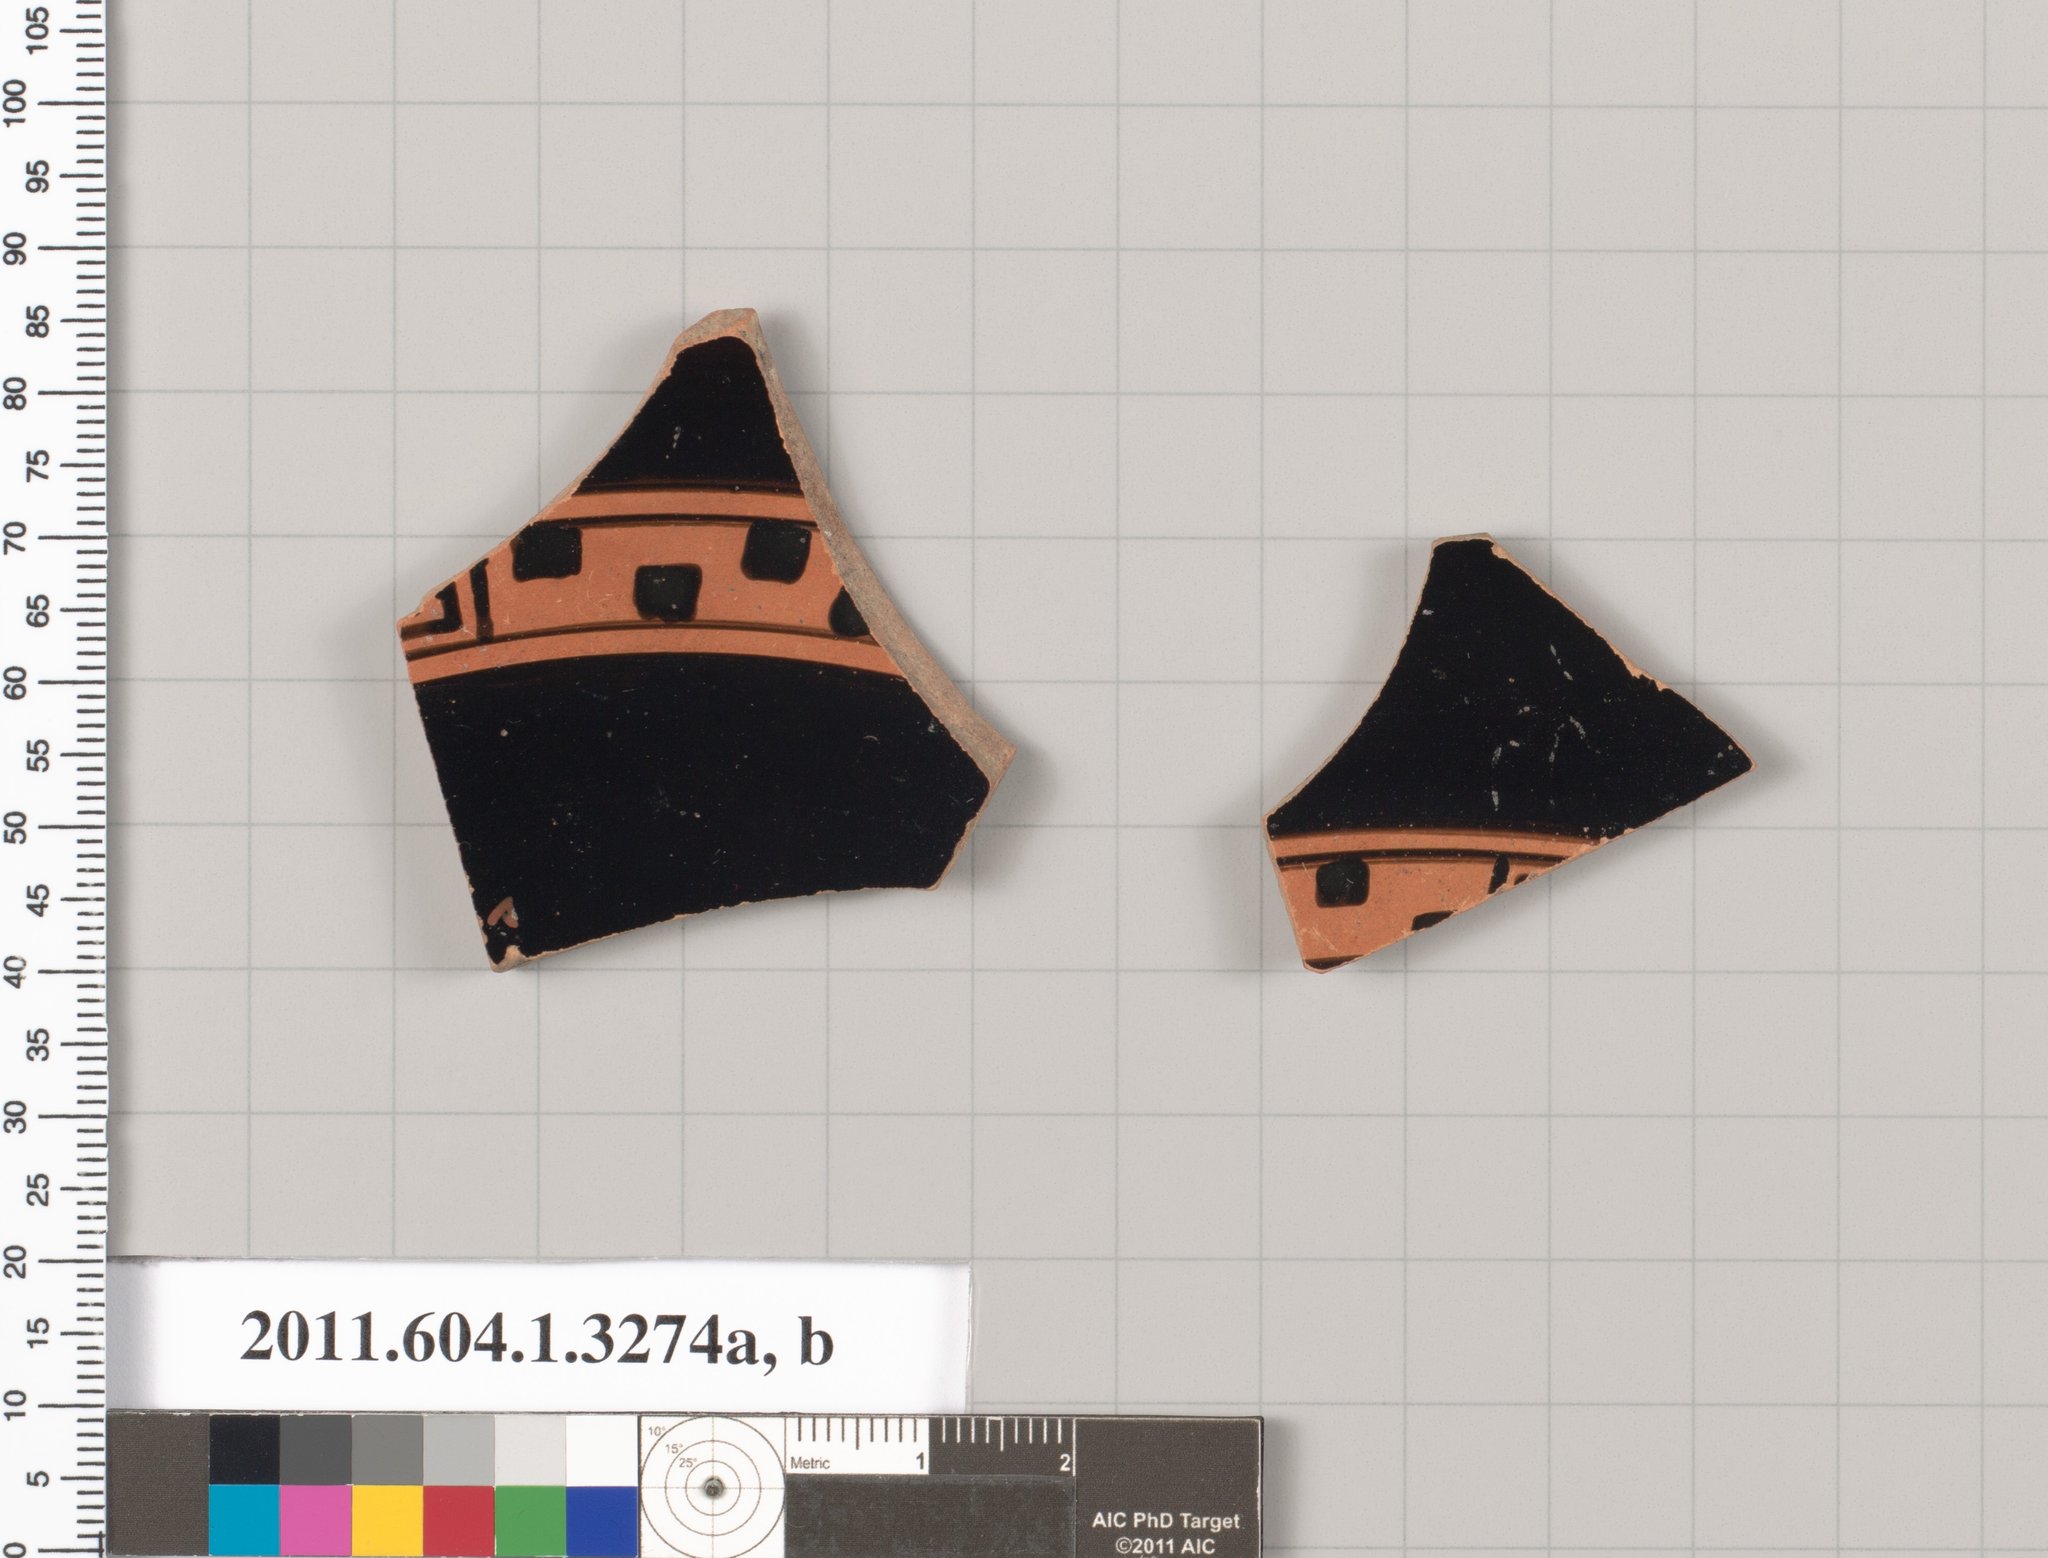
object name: kylix fragment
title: Terracotta fragments of kylikes (drinking cups)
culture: greek, attic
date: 500-490 BCE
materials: terracotta